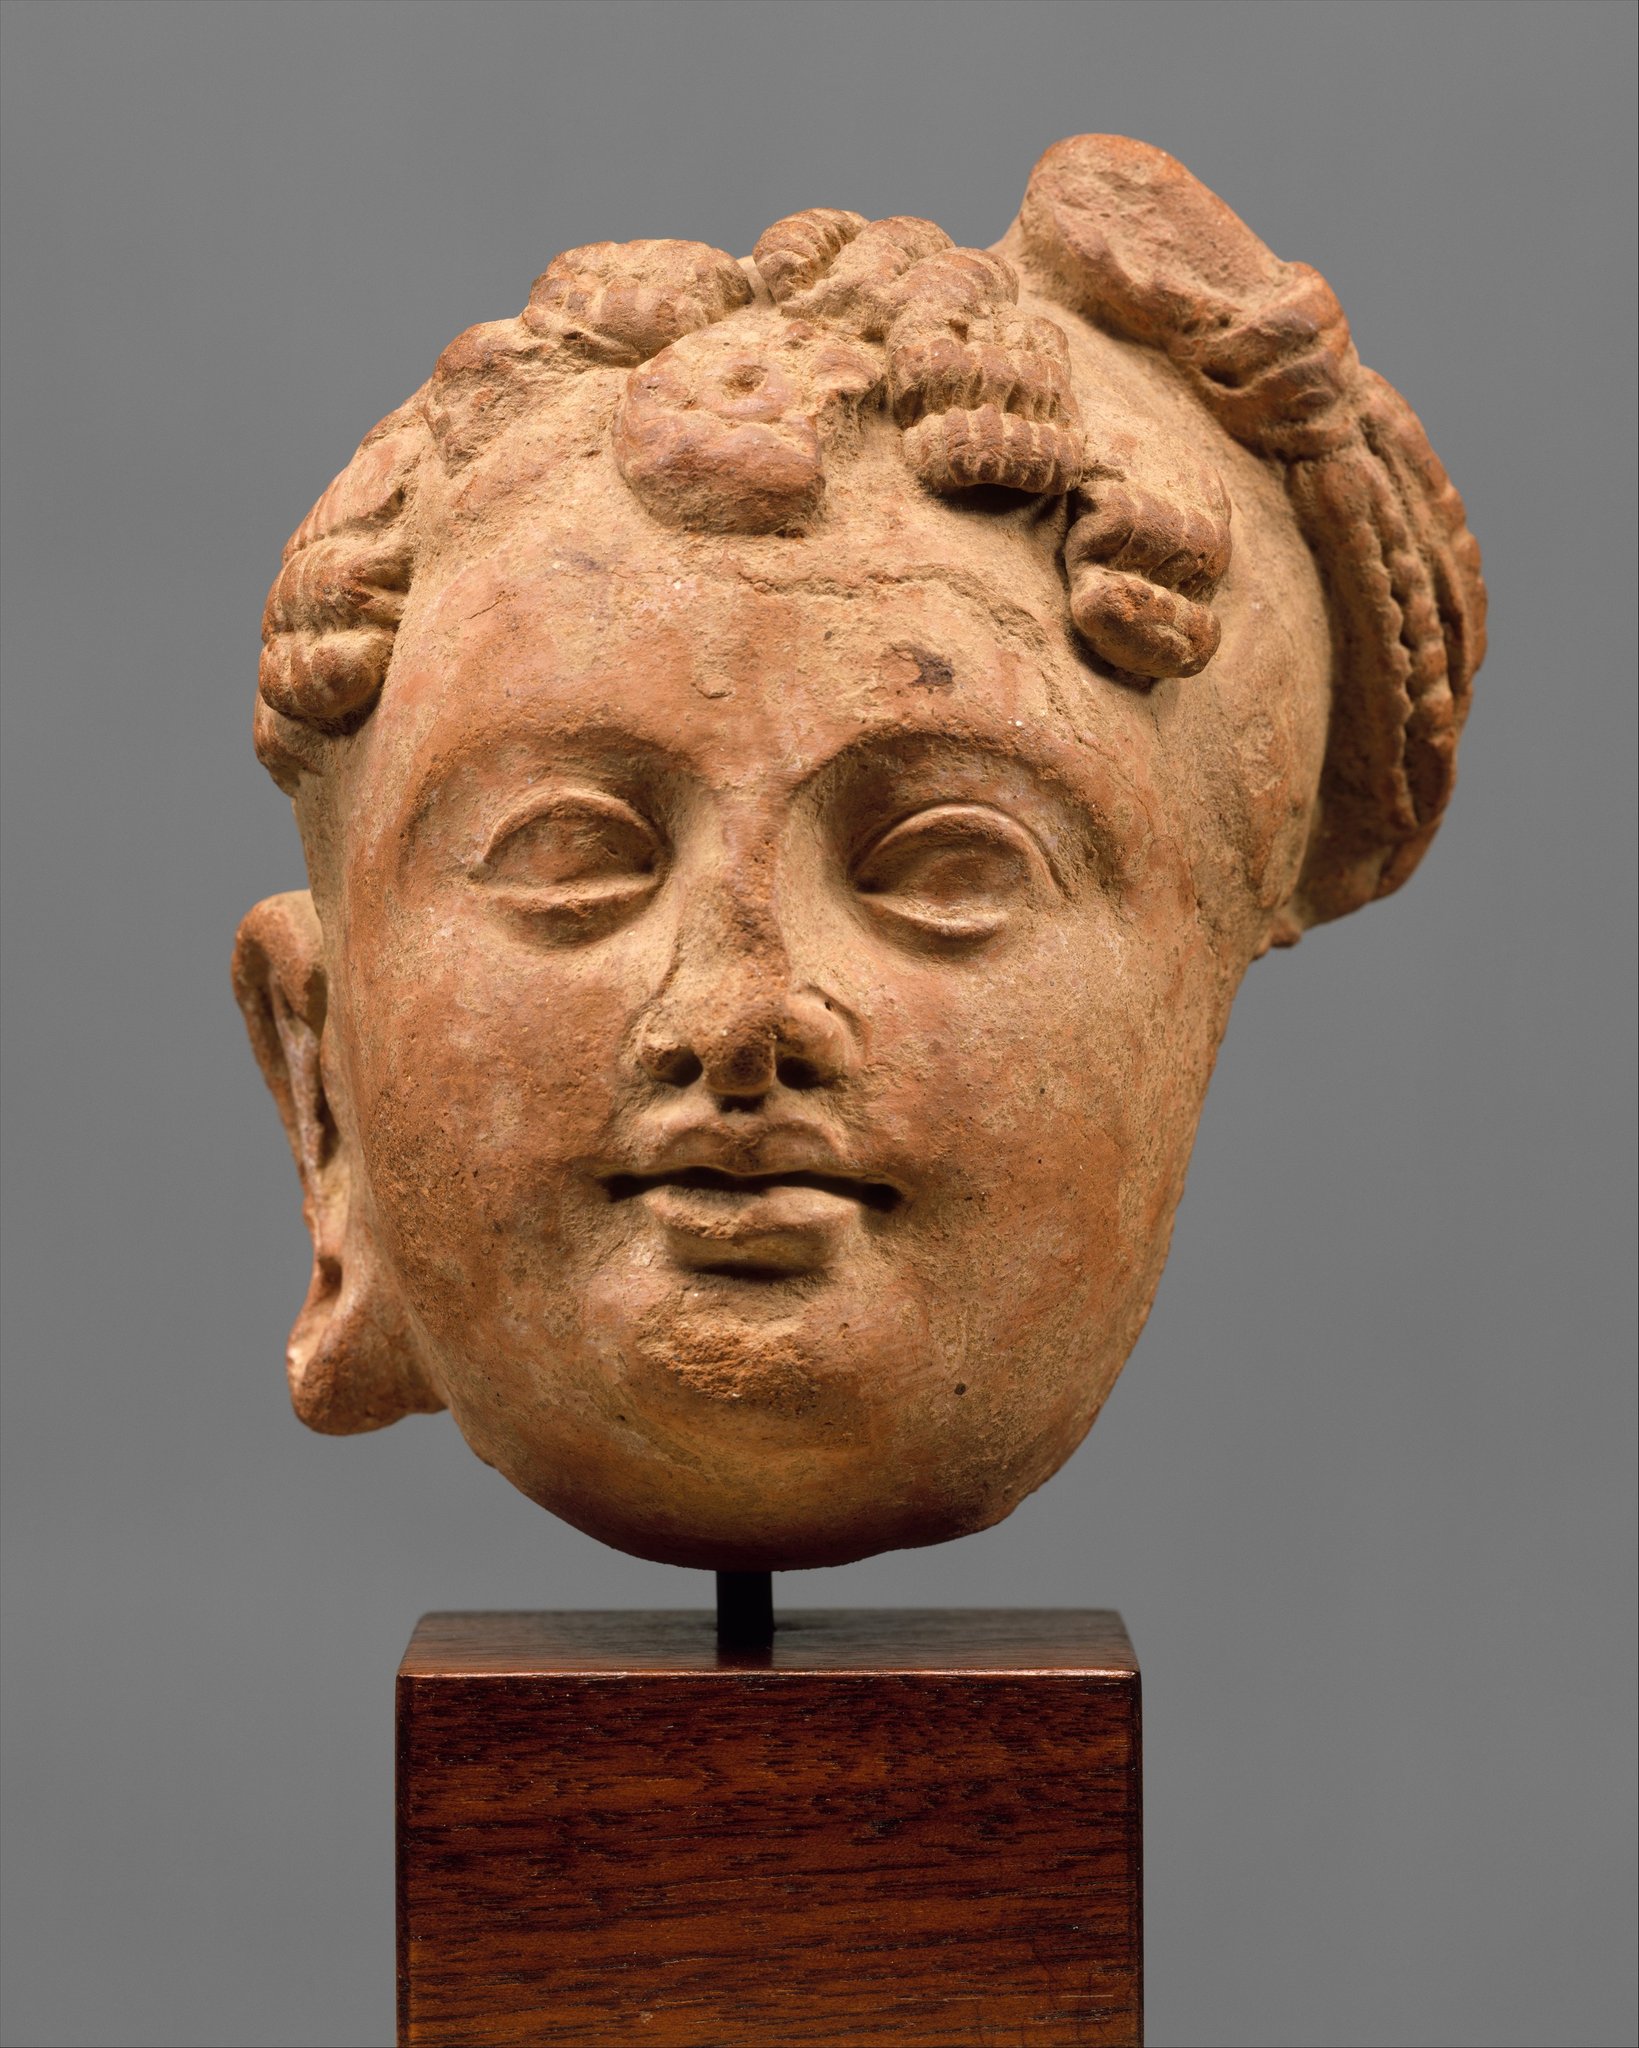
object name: head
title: Head of a Female Figure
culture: india, jammu and kashmir, akhnur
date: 501-700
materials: terracotta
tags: kashmir,heads,women